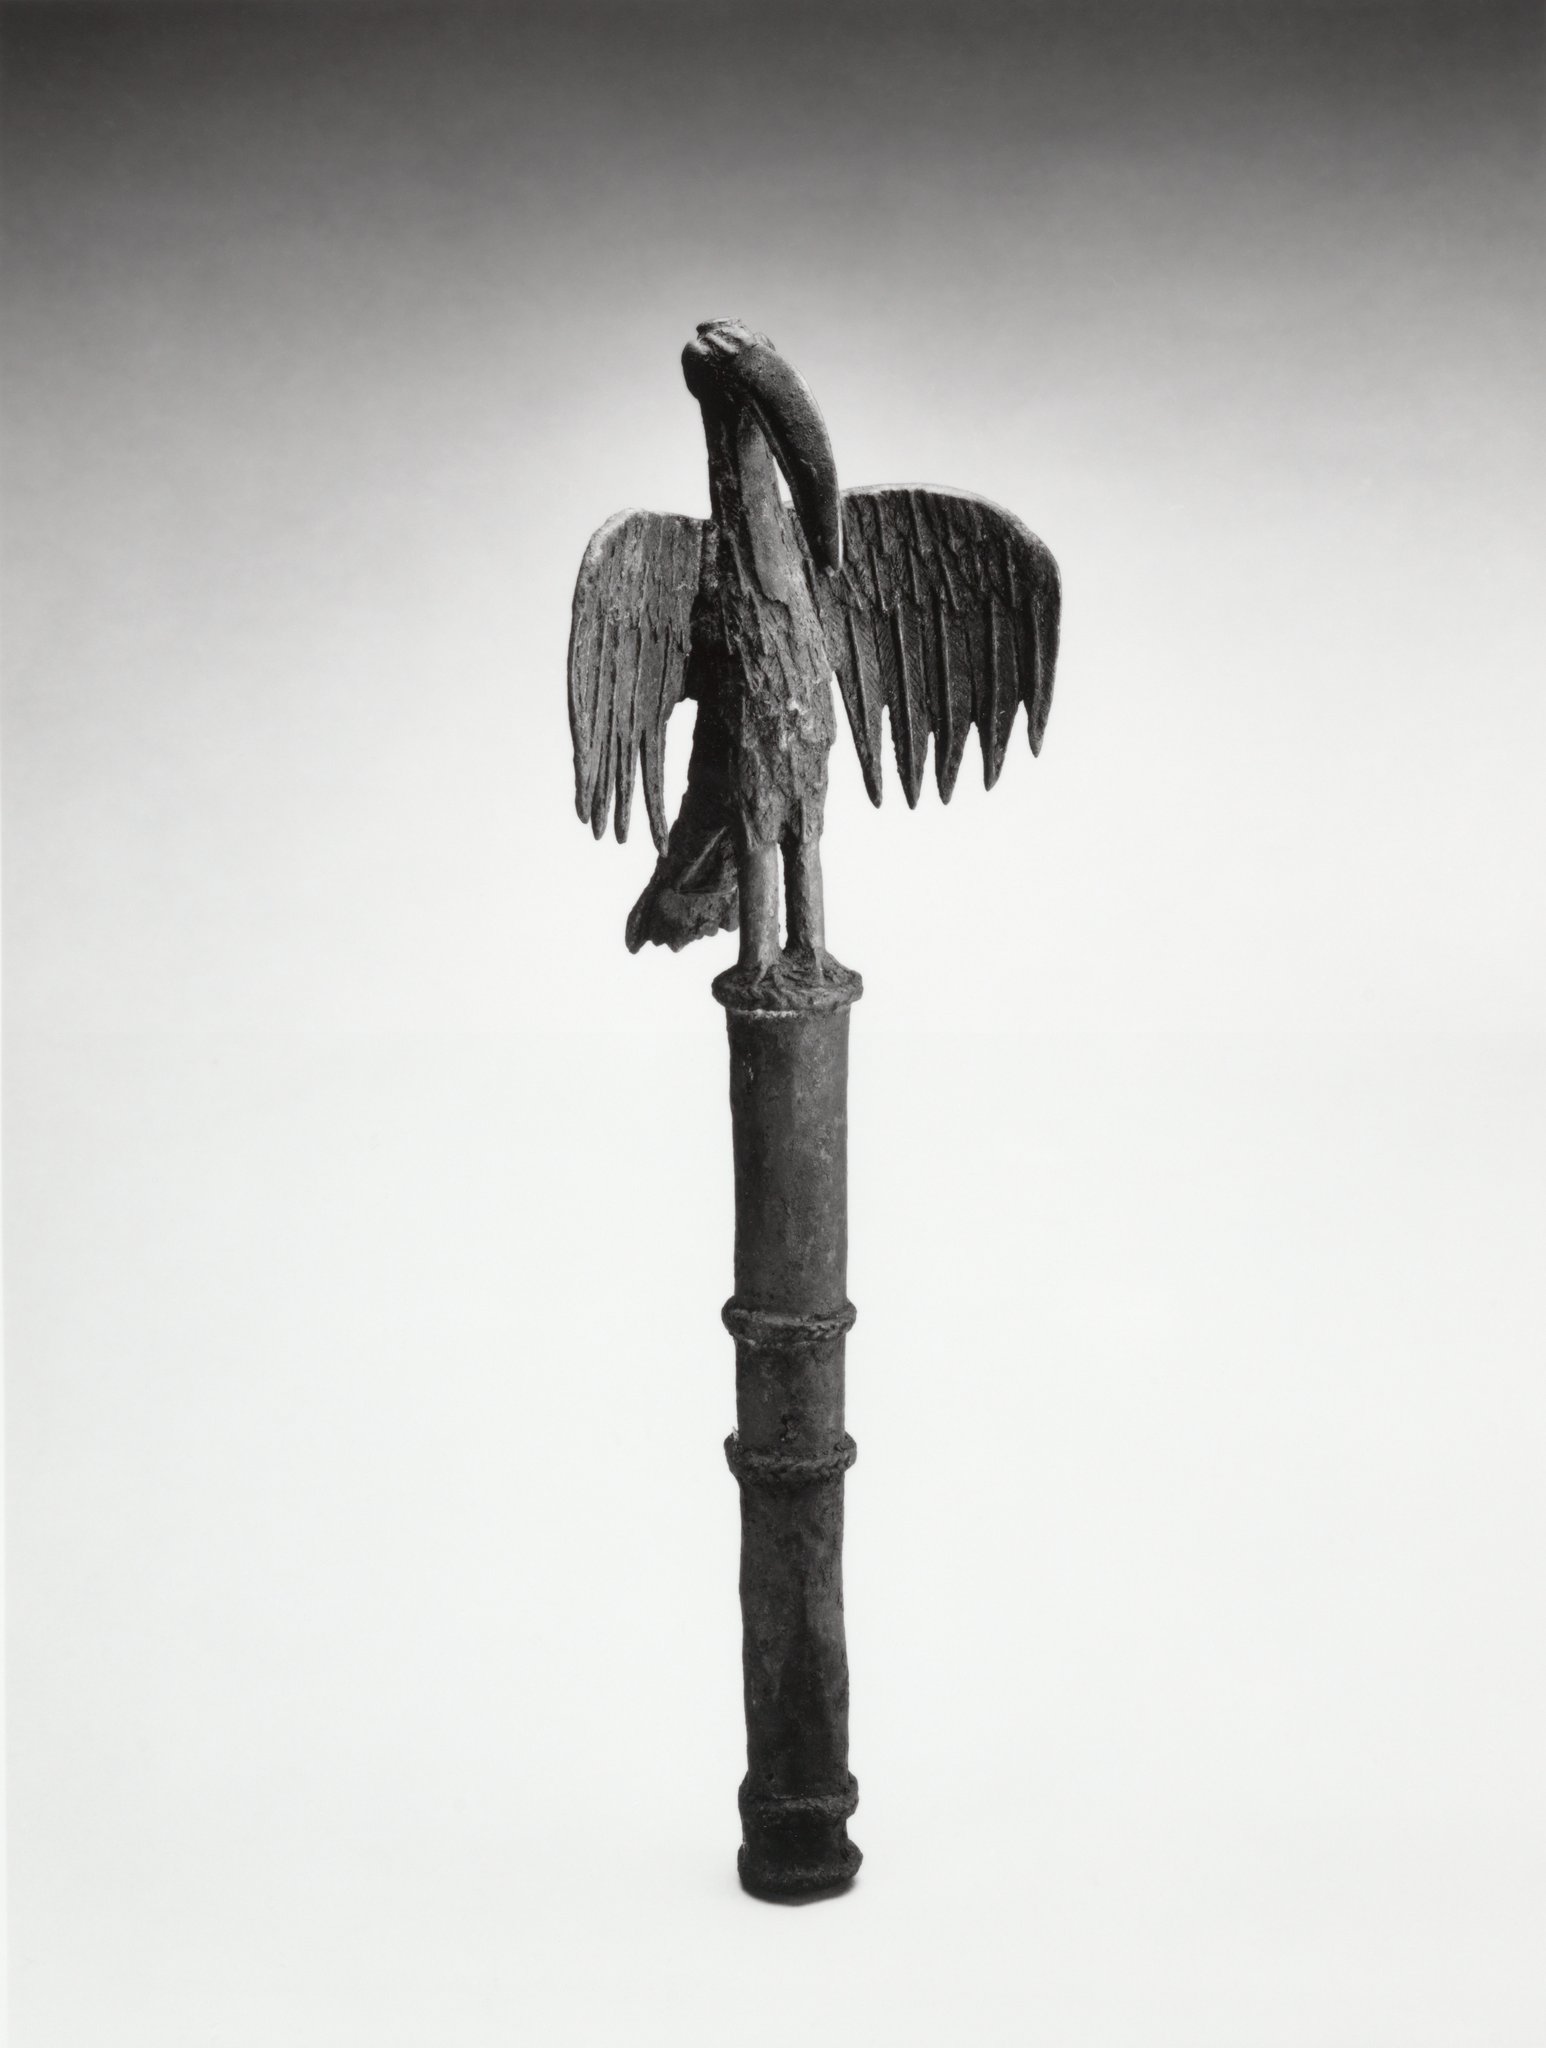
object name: idiophone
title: Idiophone: Bird of Prophecy (ahianmwen-oro)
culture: edo period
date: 1501-1900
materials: brass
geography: nigeria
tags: birds